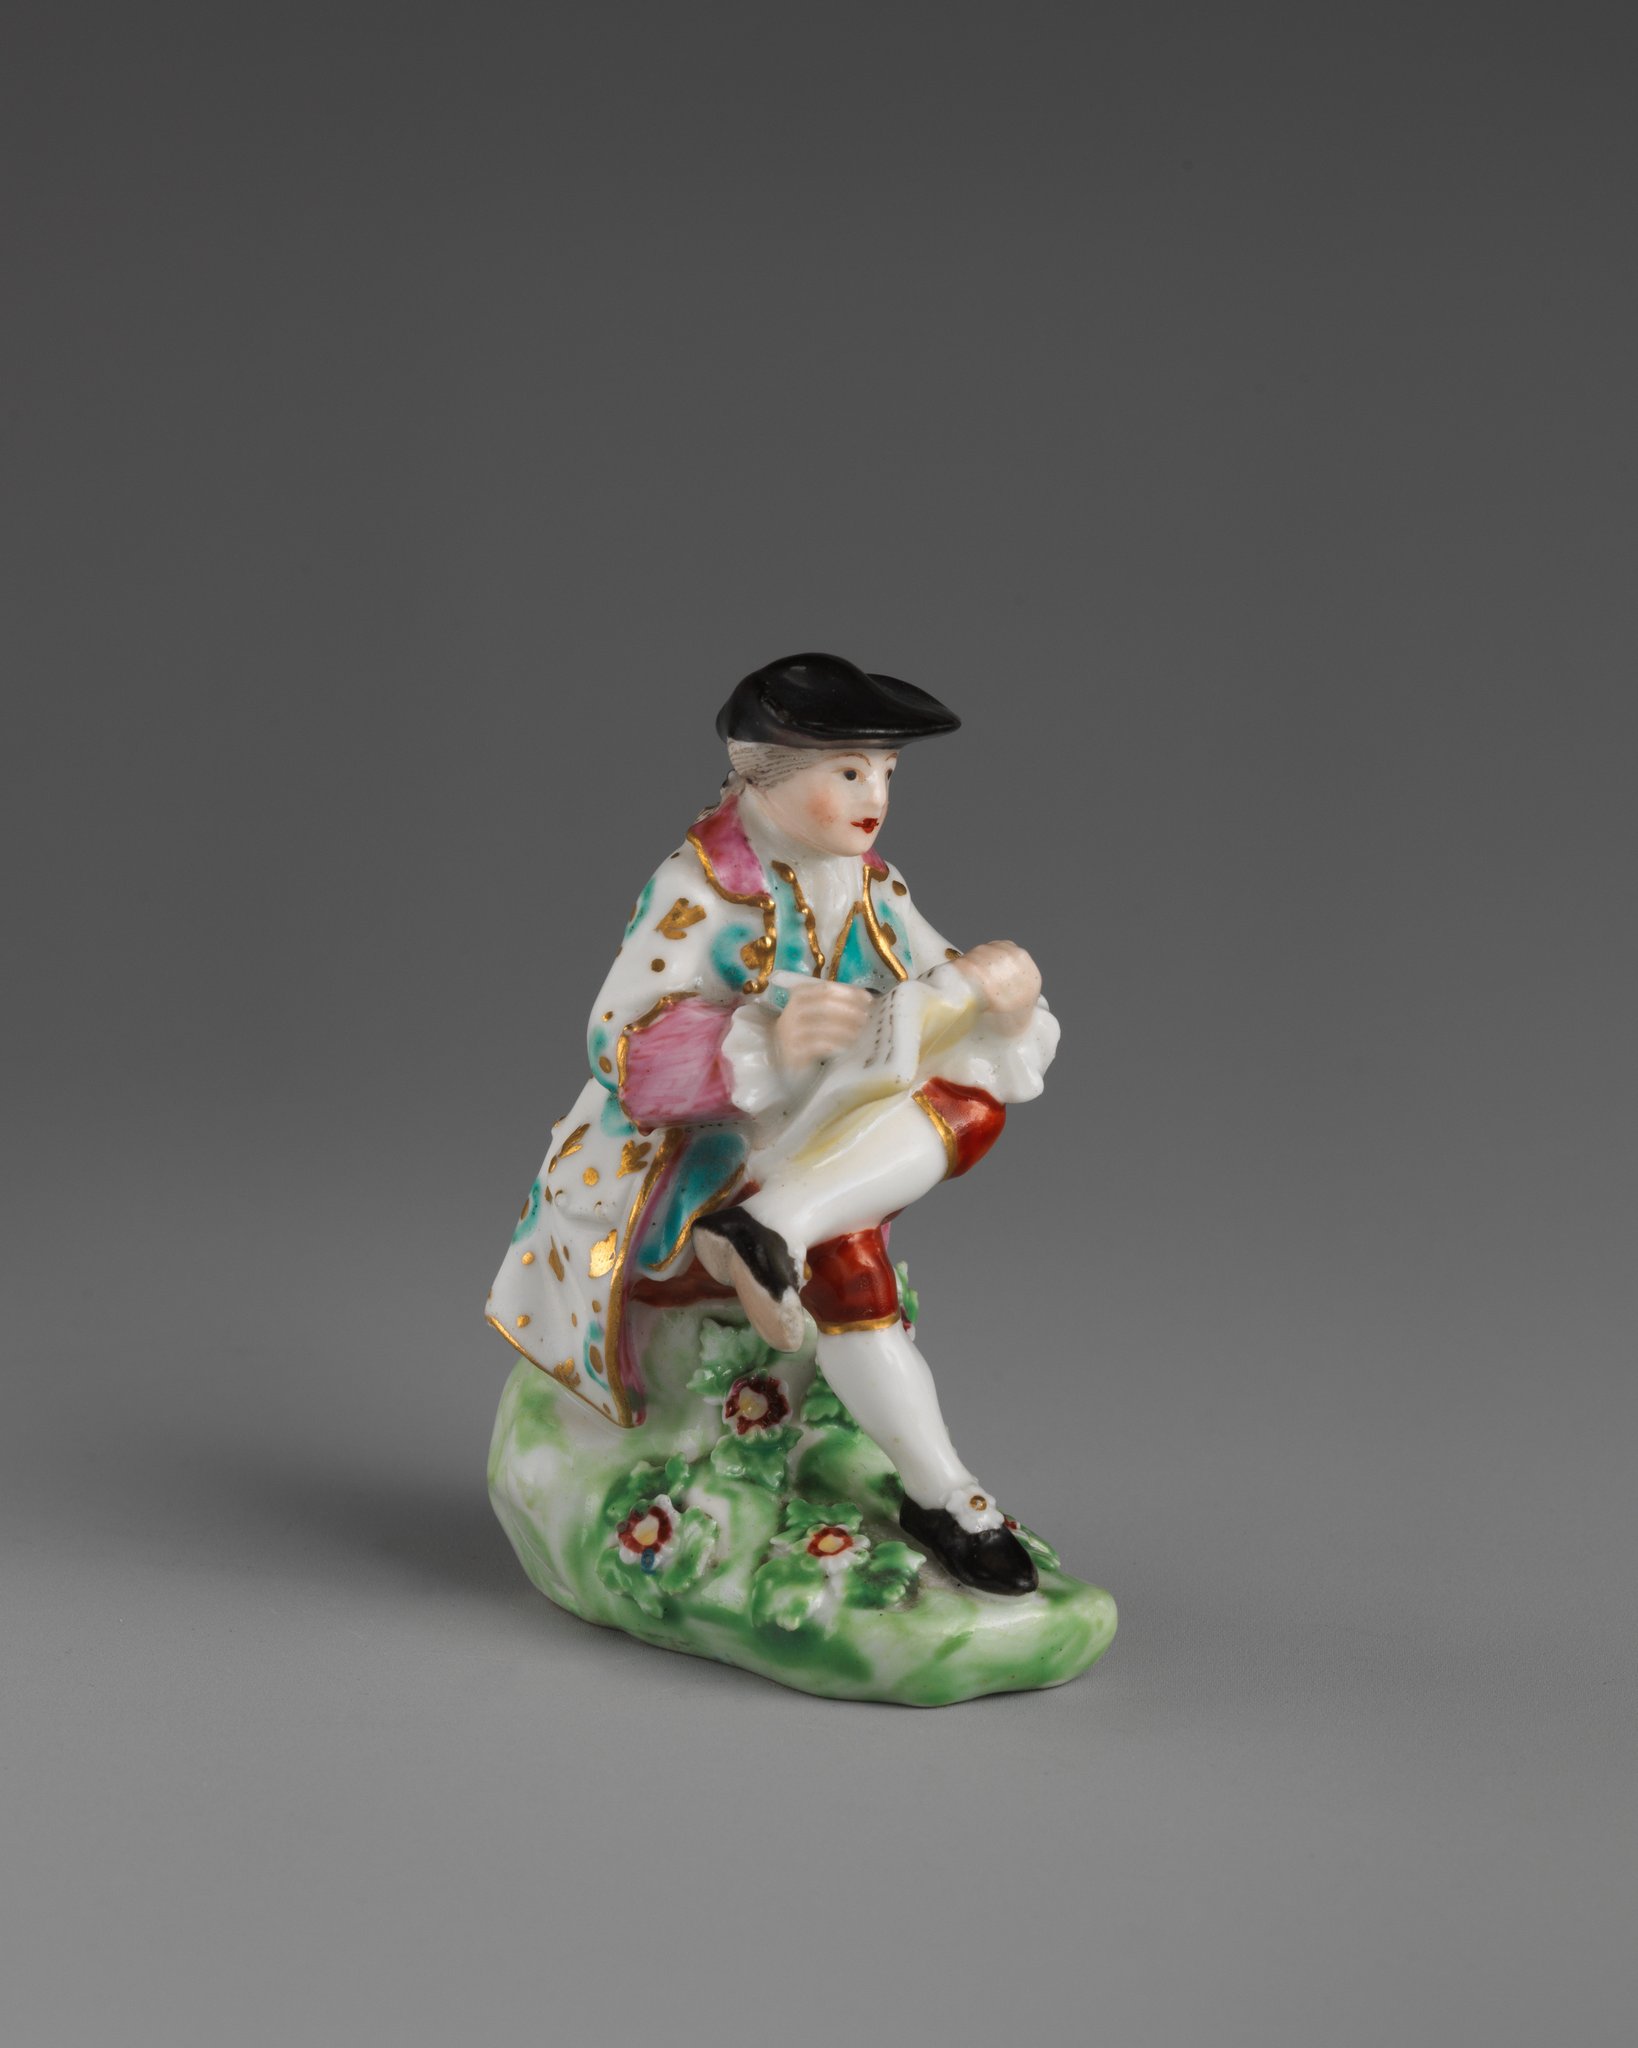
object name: toy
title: Poet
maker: derby porcelain manufactory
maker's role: factory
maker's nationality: british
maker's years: 1751-1785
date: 1765-1768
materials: soft paste porcelain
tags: men,writing